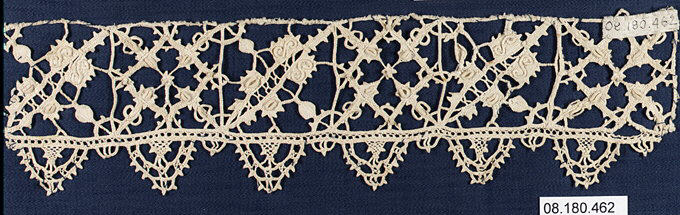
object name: band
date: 1601-1700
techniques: lace